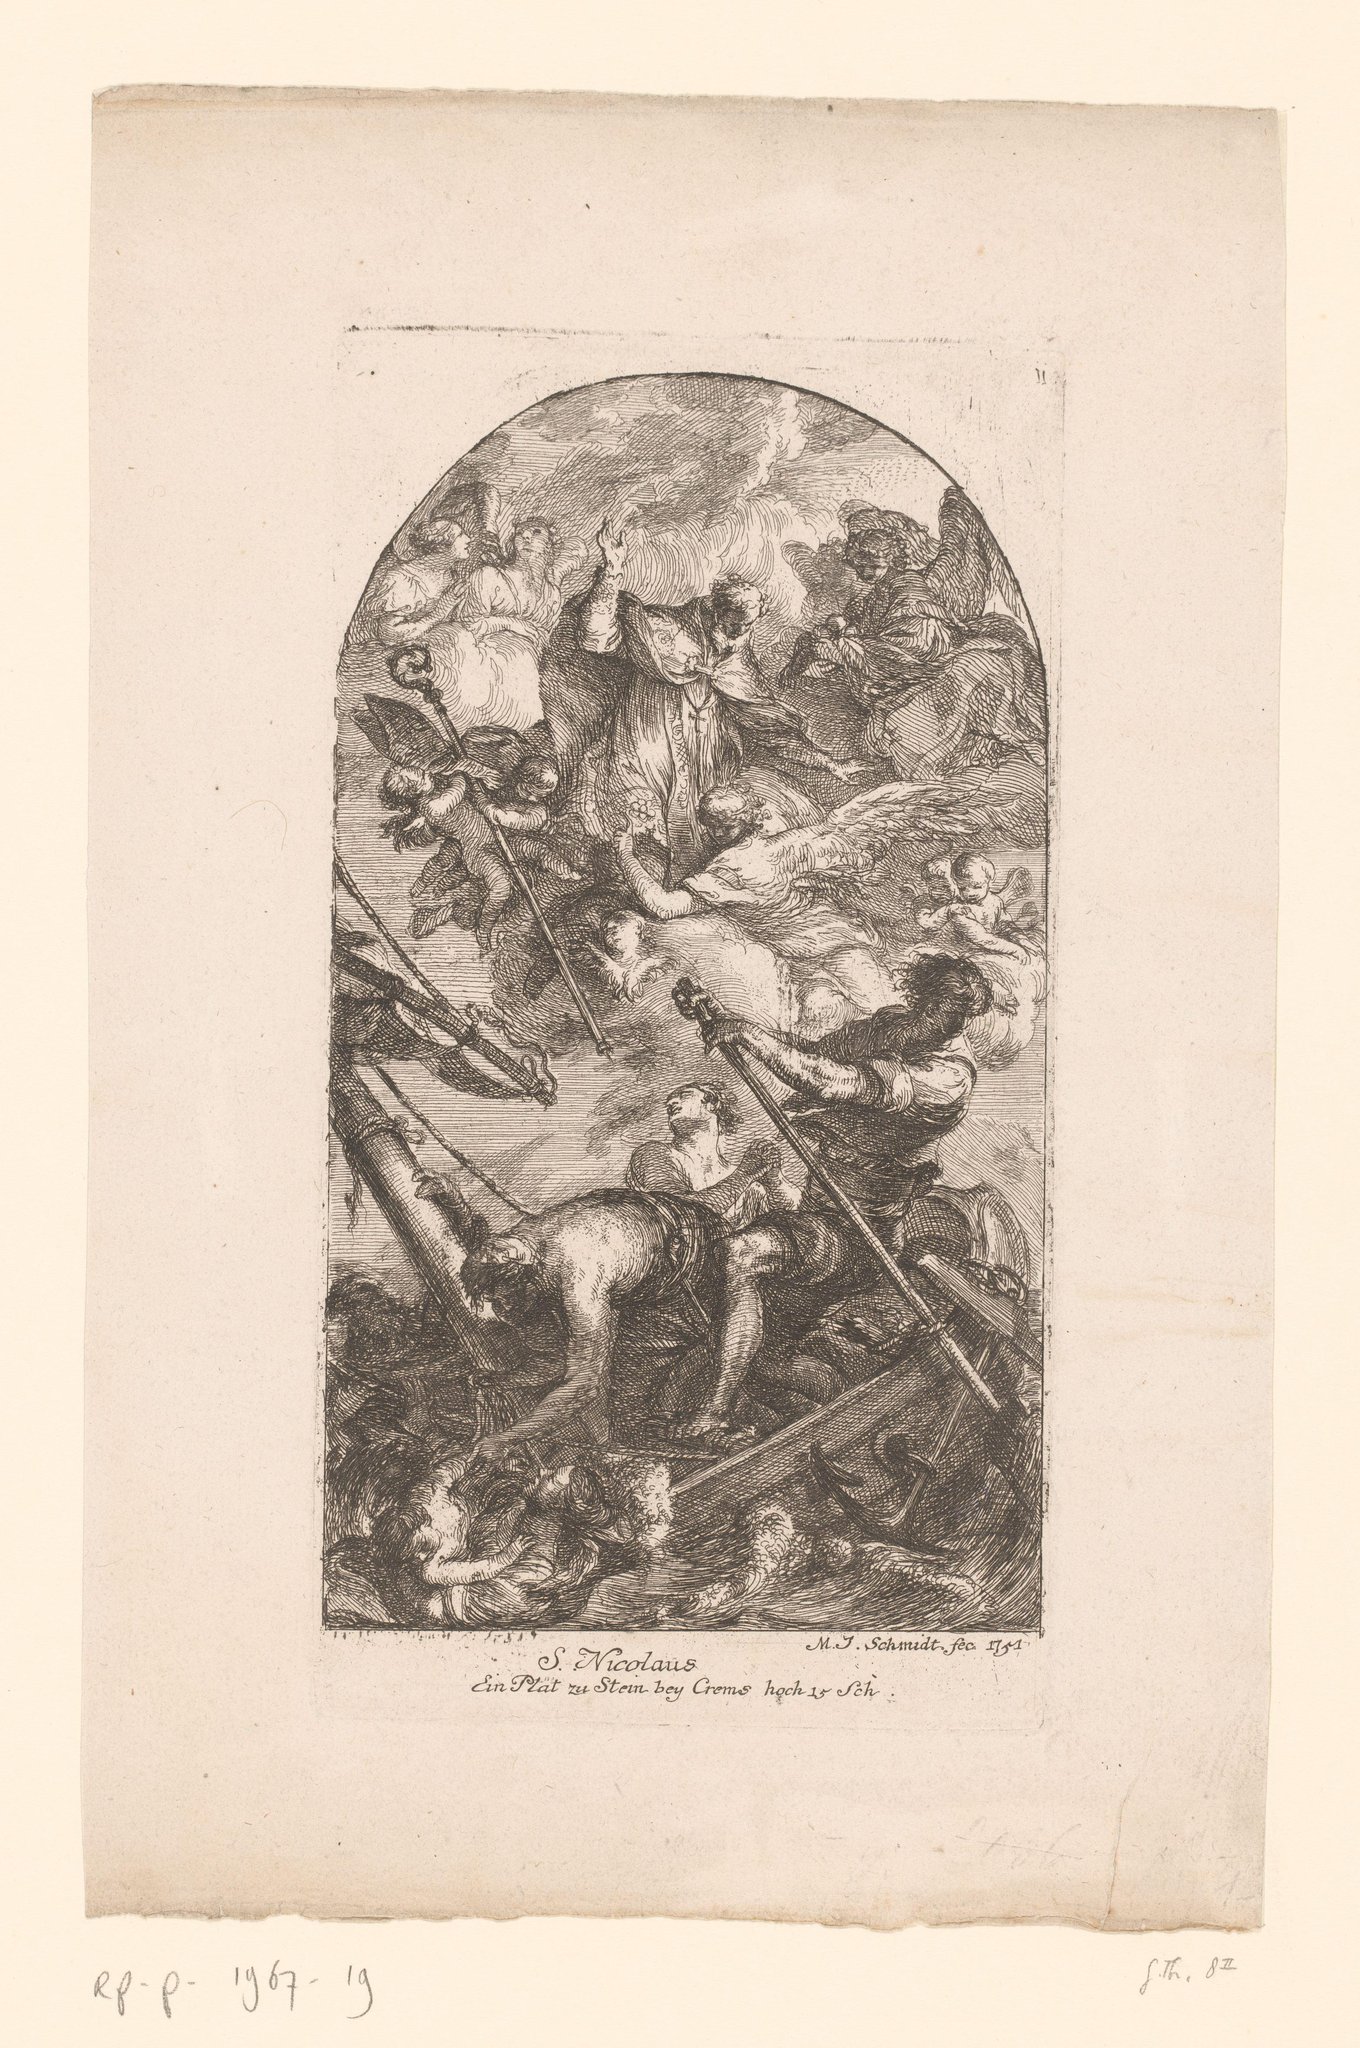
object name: print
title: Heilige Nicolaas als helper van schipbreukelingen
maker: martin johann schmidt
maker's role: draughtsman, print maker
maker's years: 1718-1801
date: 1751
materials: paper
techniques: etching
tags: the bishop nicholas of myra (or bari); possible attributes: anchor, boat, three golden balls (on a book), three purses, three children in a tub, three maidens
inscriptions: collector's mark: Lugt 2760, collector's mark: Lugt 2228, collector's mark: Lugt 906